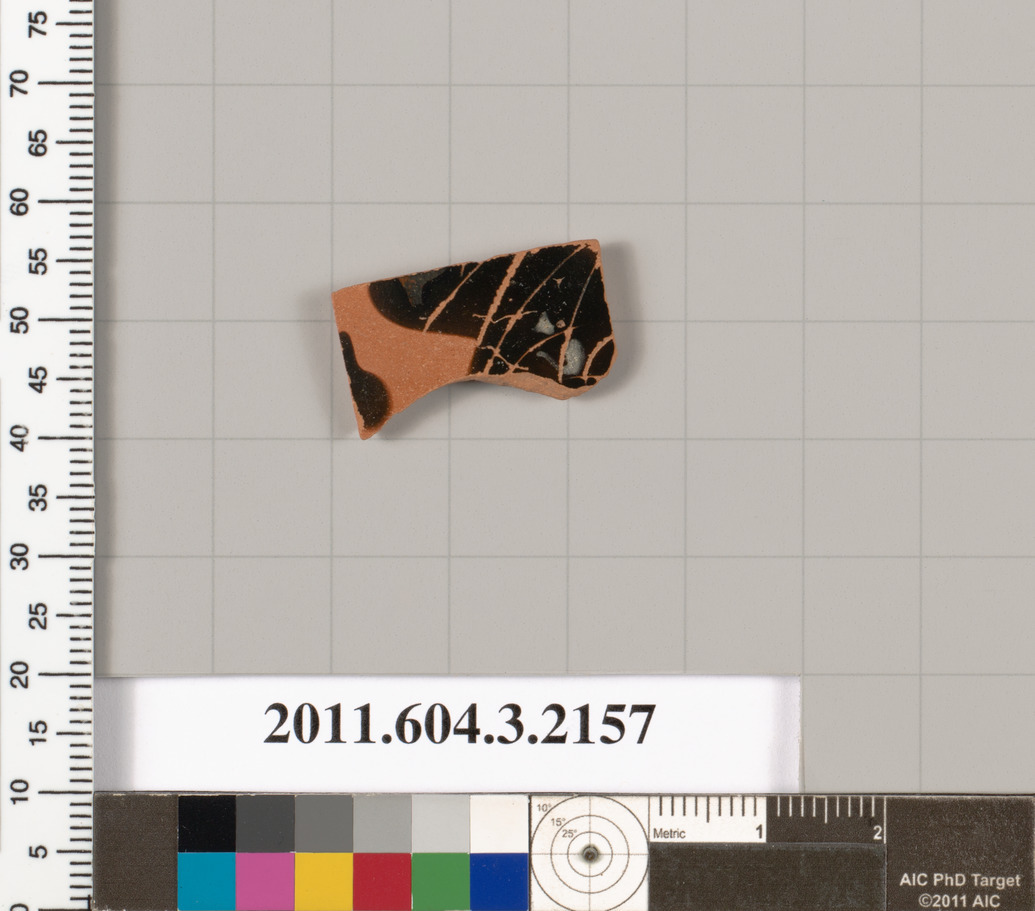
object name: kylix fragment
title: Terracotta fragment of a kylix (drinking cup)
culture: greek, attic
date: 534-468 BCE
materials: terracotta